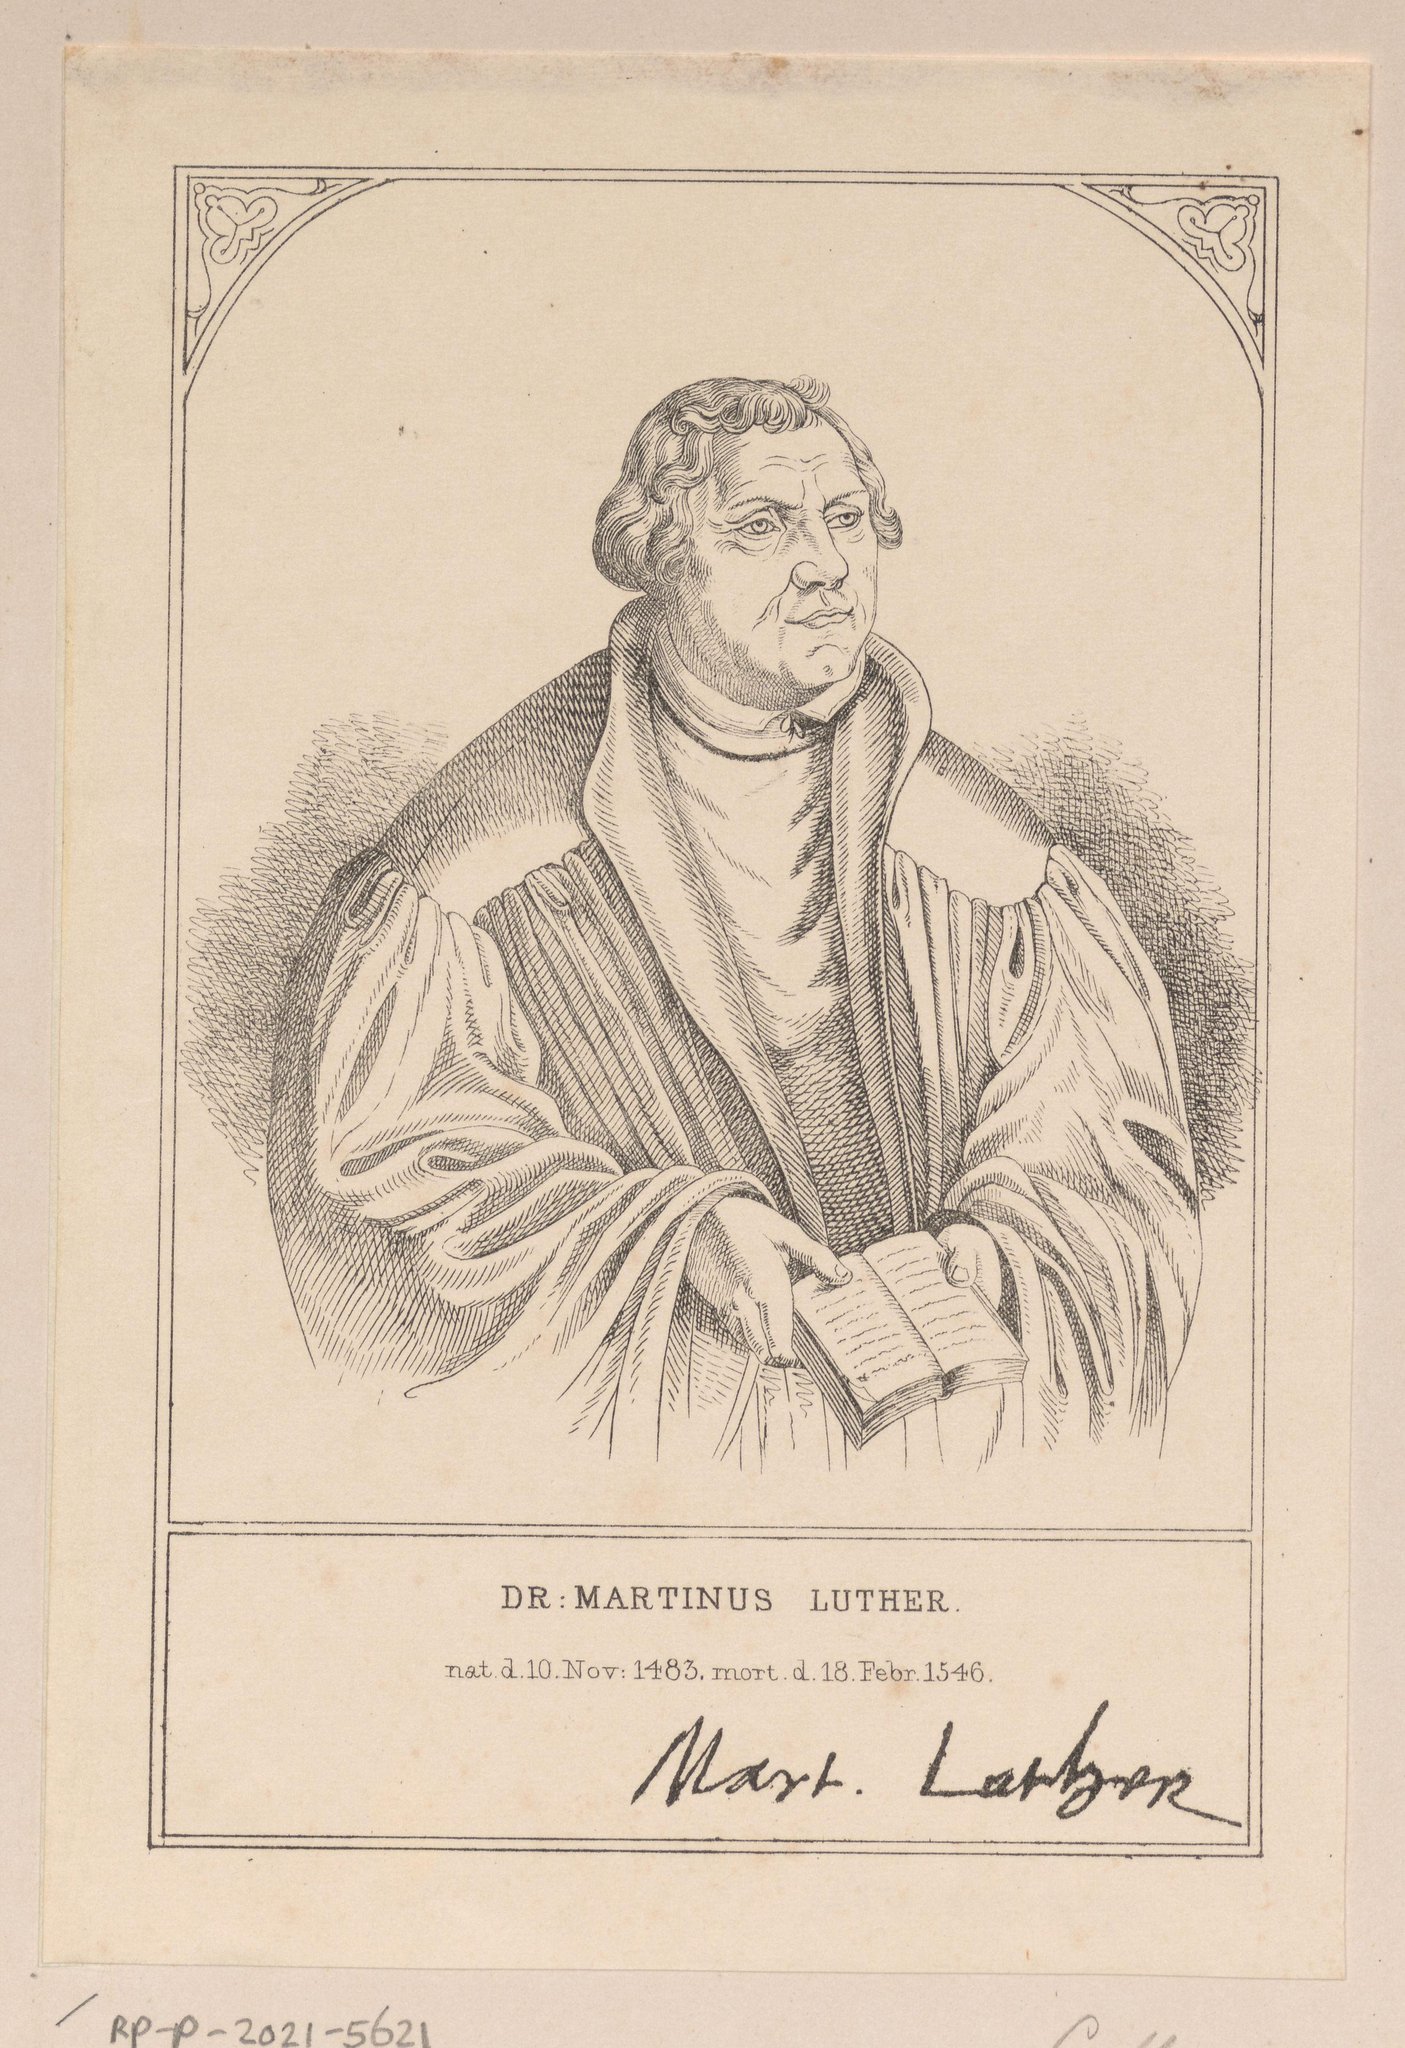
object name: print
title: Portret van Martin Luther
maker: Anonymous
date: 1800-1899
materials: paper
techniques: lithograph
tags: priest, martin luther, theologian, historical persons, book - mm - book open